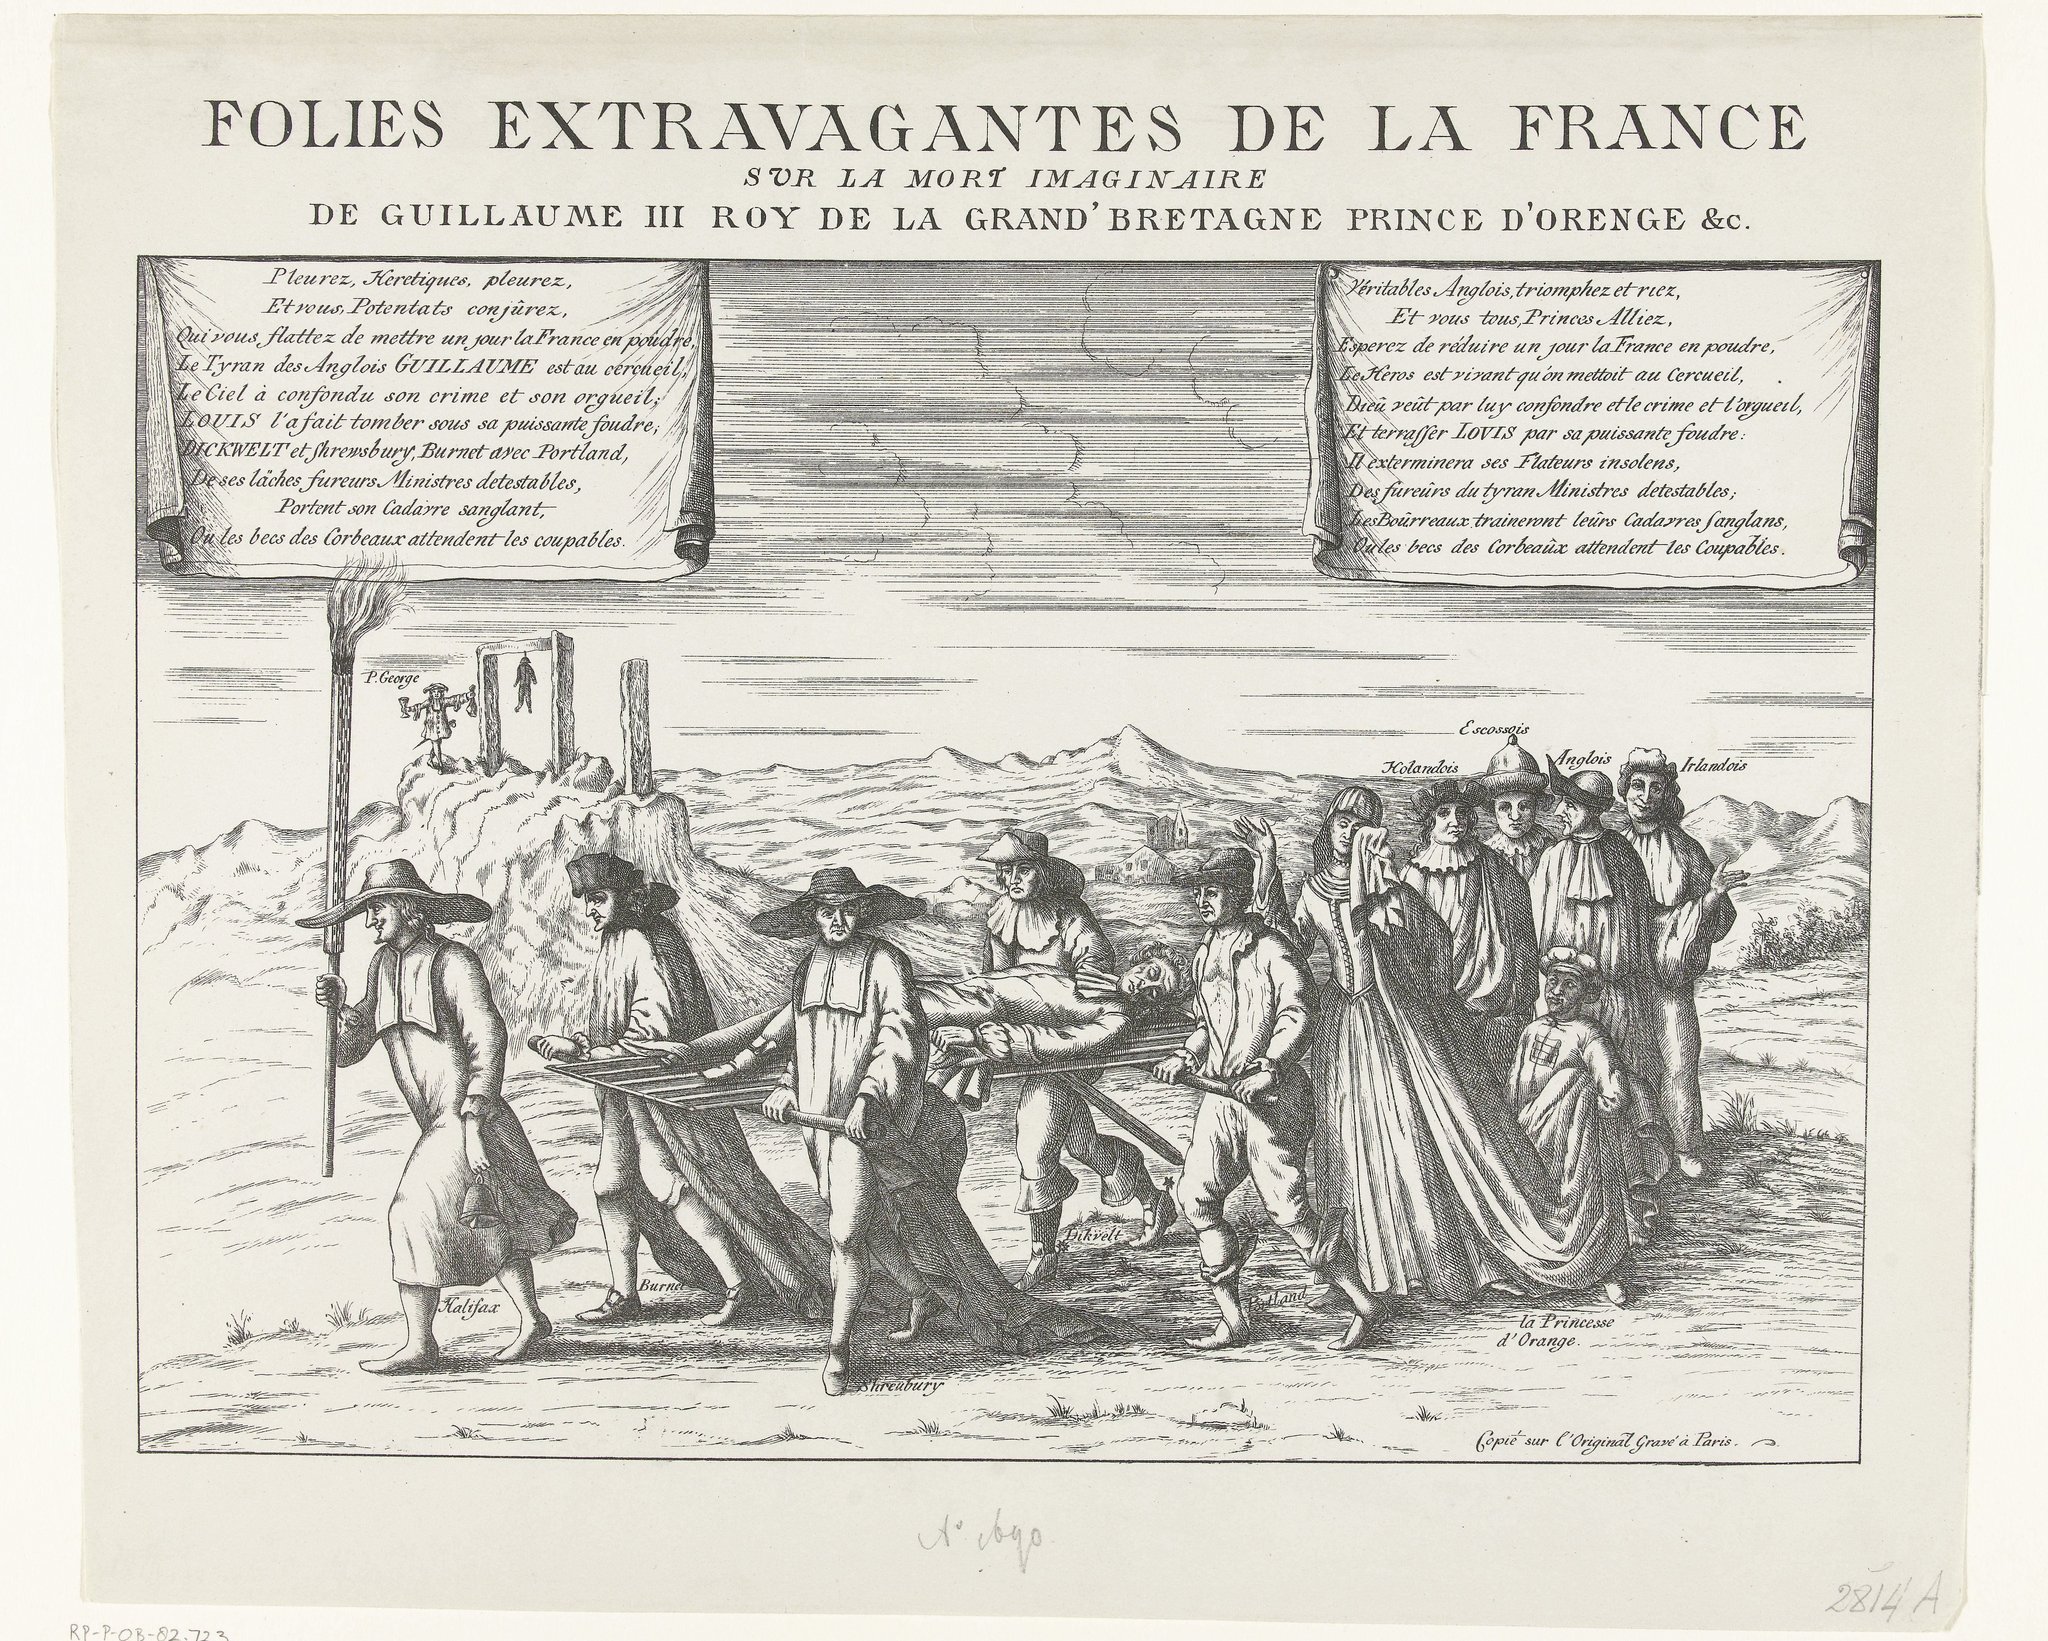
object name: cartoon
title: Folies Extravagantes de la France sur la Mort Imaginaire de Guillaume III Roy de la Grand' Bretagne Prince d'Orenge &c.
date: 1877-1879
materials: paper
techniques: lithograph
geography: netherlands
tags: the hague, william iii (prince of orange and king of england, scotland, and ireland), london, maria ii stuart (koningin van engeland, schotland en ierland), clergyman, earl, cortege, funeral procession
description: Moderne reproductie van de Hollandse reproductie van een Franse spotprent op de vermeende dood van Willem III tijdens de slag aan de Boyne op 11 juli 1690. Begrafenisstoet waarin het lichaam van de dode Willem III op een brancard wordt gedragen, voorop George Savile, eerste markies van Halifax, met een toorts, gevolgd door de dragers: bisschop Gilbert Burnet, Charles Talbot, twaalfde graaf van Shrewsbury, Everhard van Weede van Dijkvelt en de graaf van Portland. Achter de baar de prinses van Oranje, een Hollander, een Engelsman, een Schot en een Ier. Linksachter een galg. Zonder de teksten onder de voorstelling.